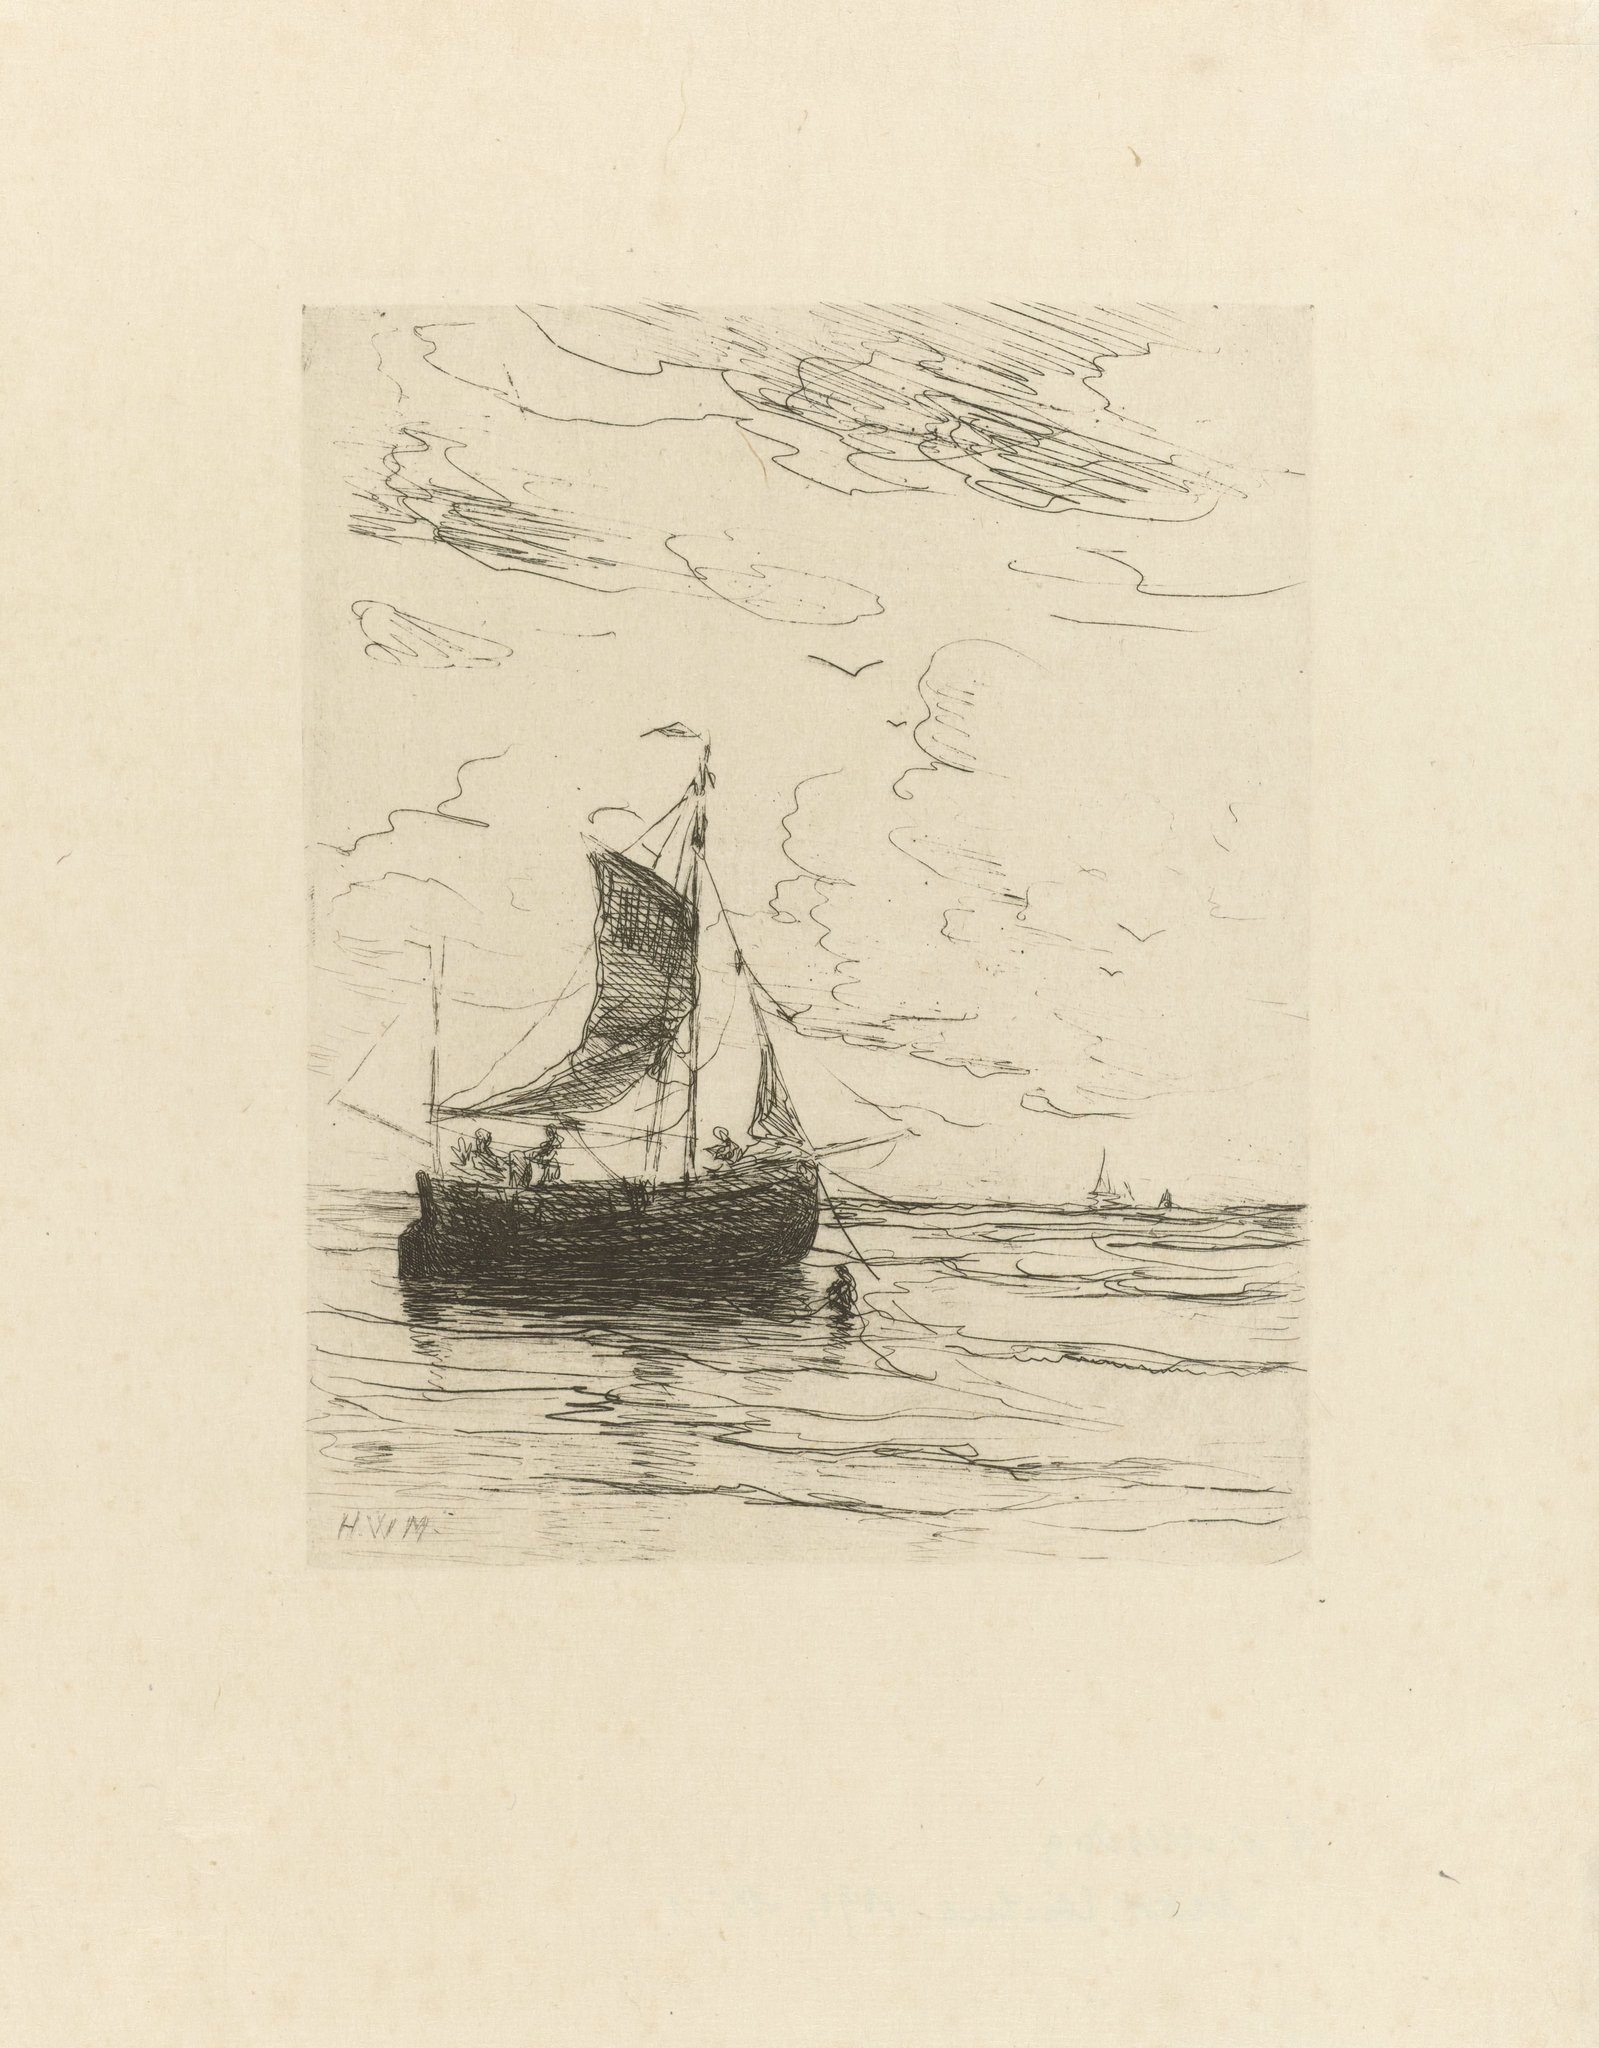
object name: print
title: Vissersboot voor de kust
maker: hendrik willem mesdag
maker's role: draughtsman, painter, print maker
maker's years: 1831-1915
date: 1891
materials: paper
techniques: etching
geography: netherlands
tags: sailing-ship, sailing-boat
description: Gemaakt voor de tentoonstelling van de Nederlandsche etsclub in 1891, nr. 1.